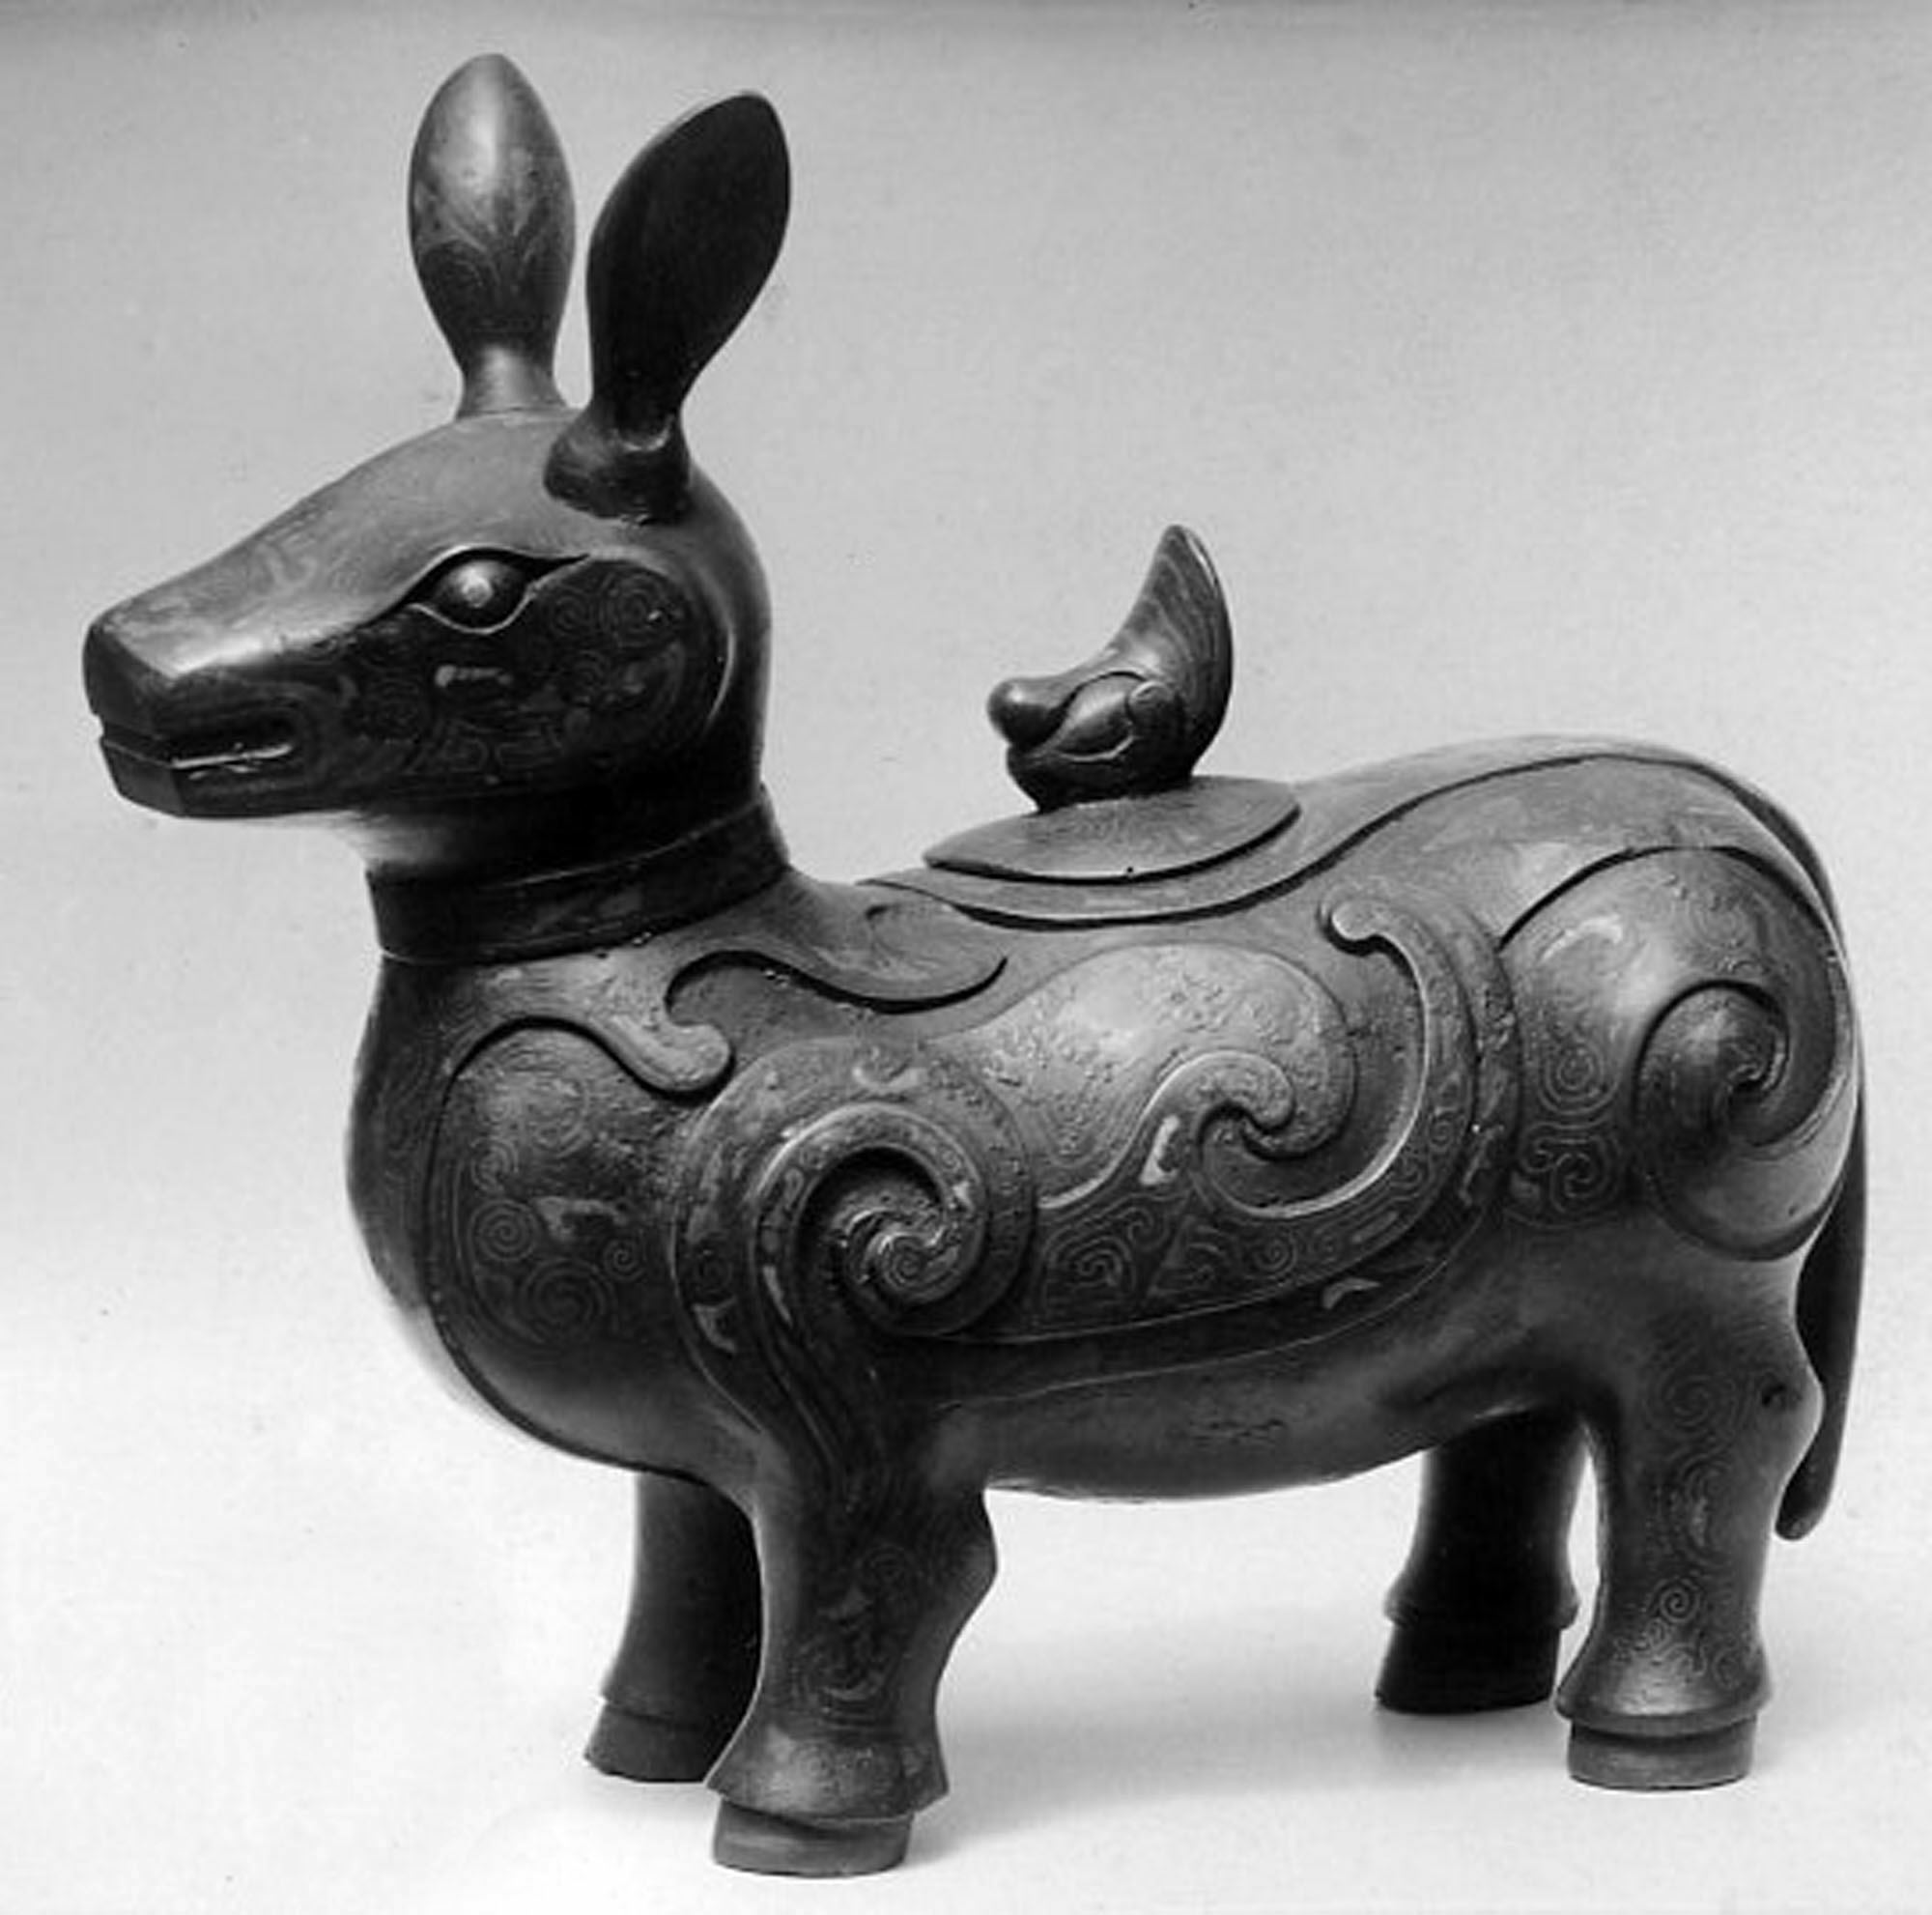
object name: wine vessel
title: Covered Wine Vessel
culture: chinese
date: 1368-1644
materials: bronze, gold, silver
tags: animals